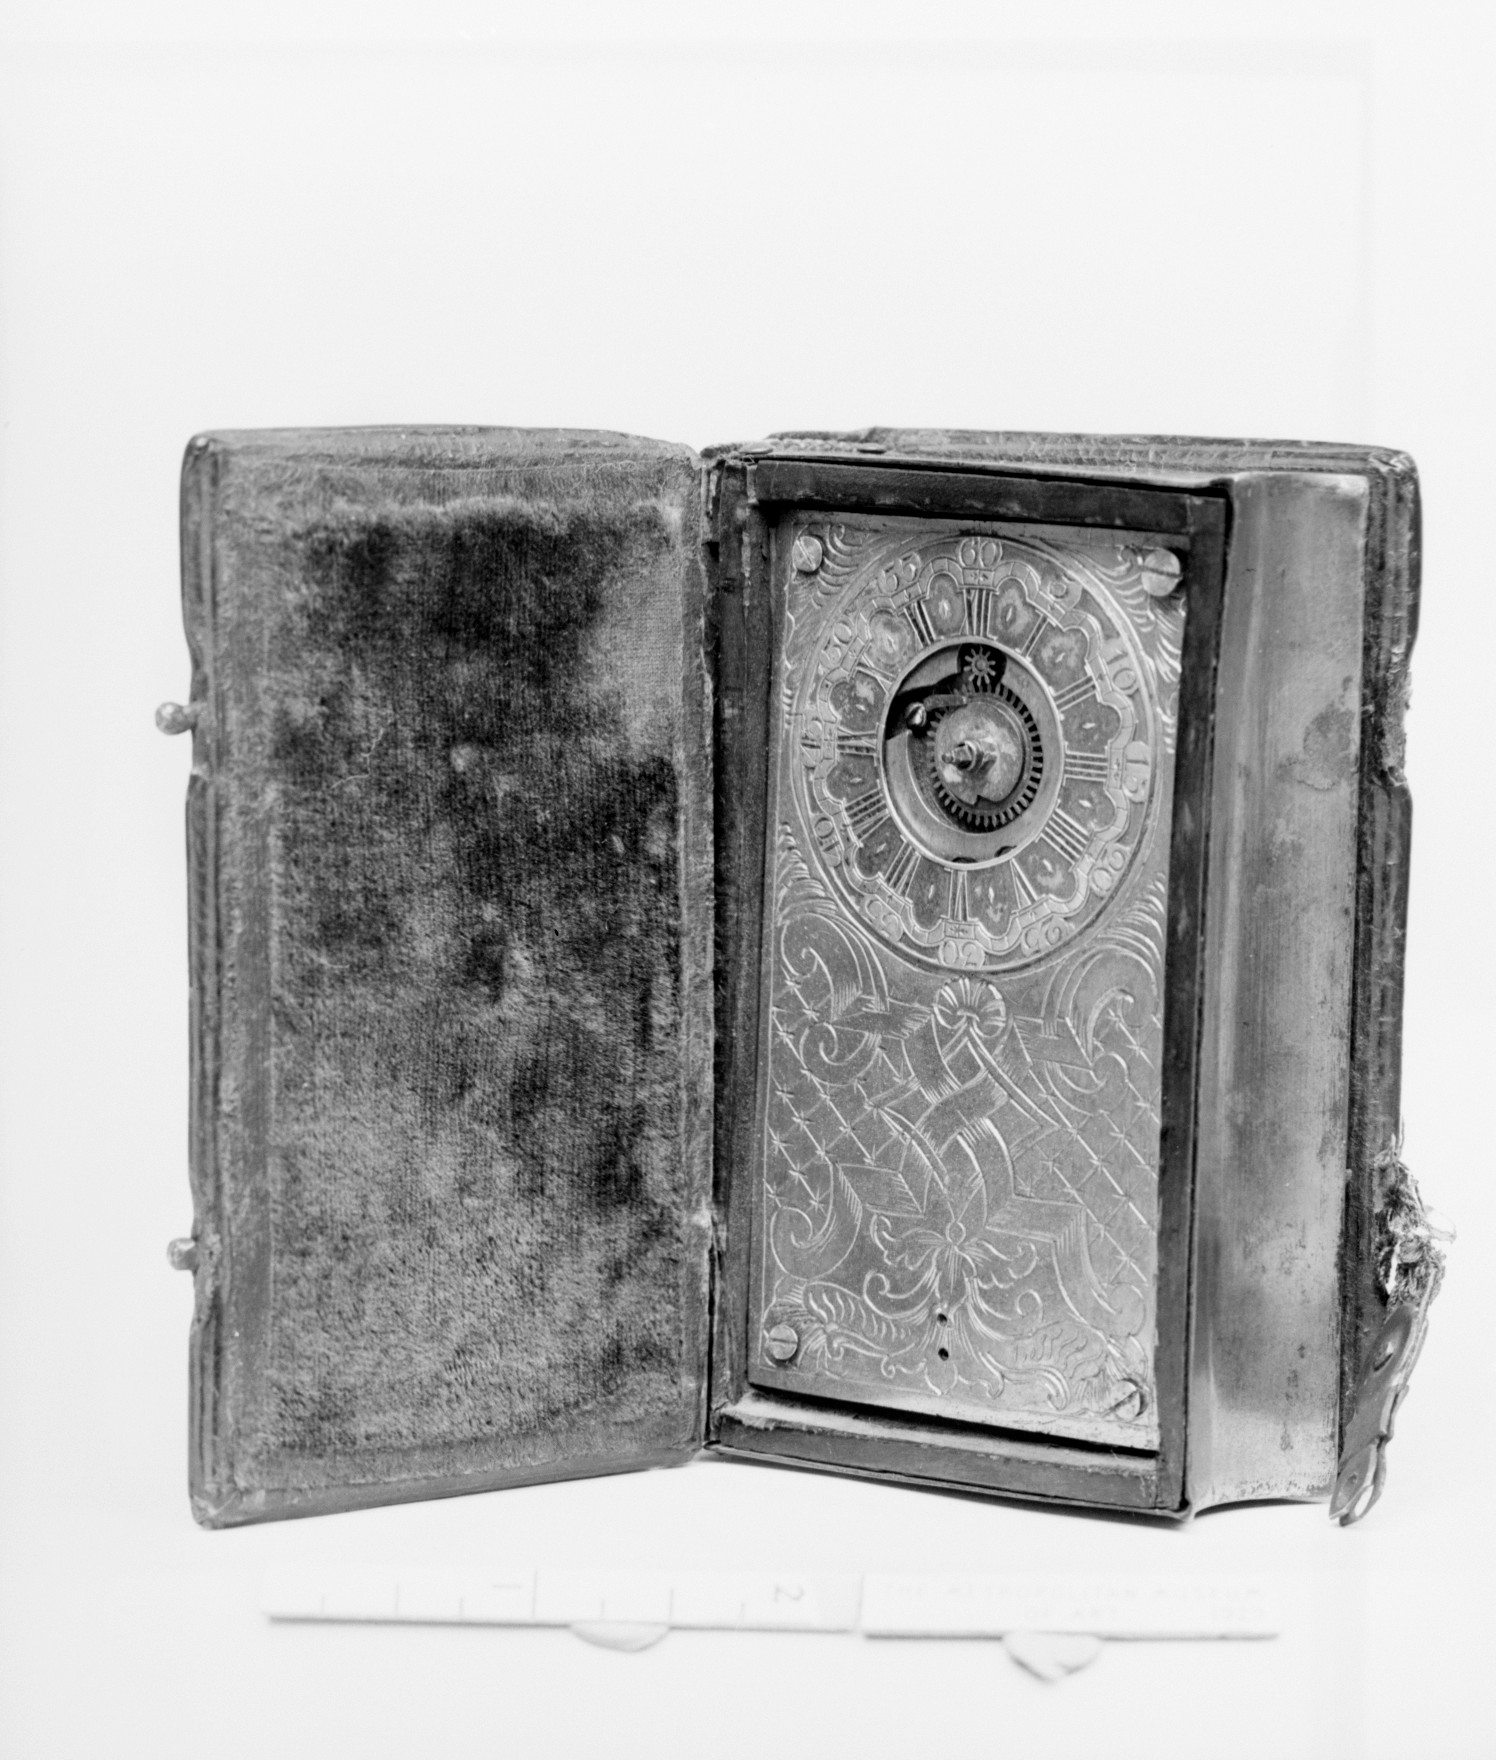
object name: clock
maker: joh georg wagner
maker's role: maker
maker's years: 1625-1725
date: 1667-1700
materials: gilt bronze, leather, wood